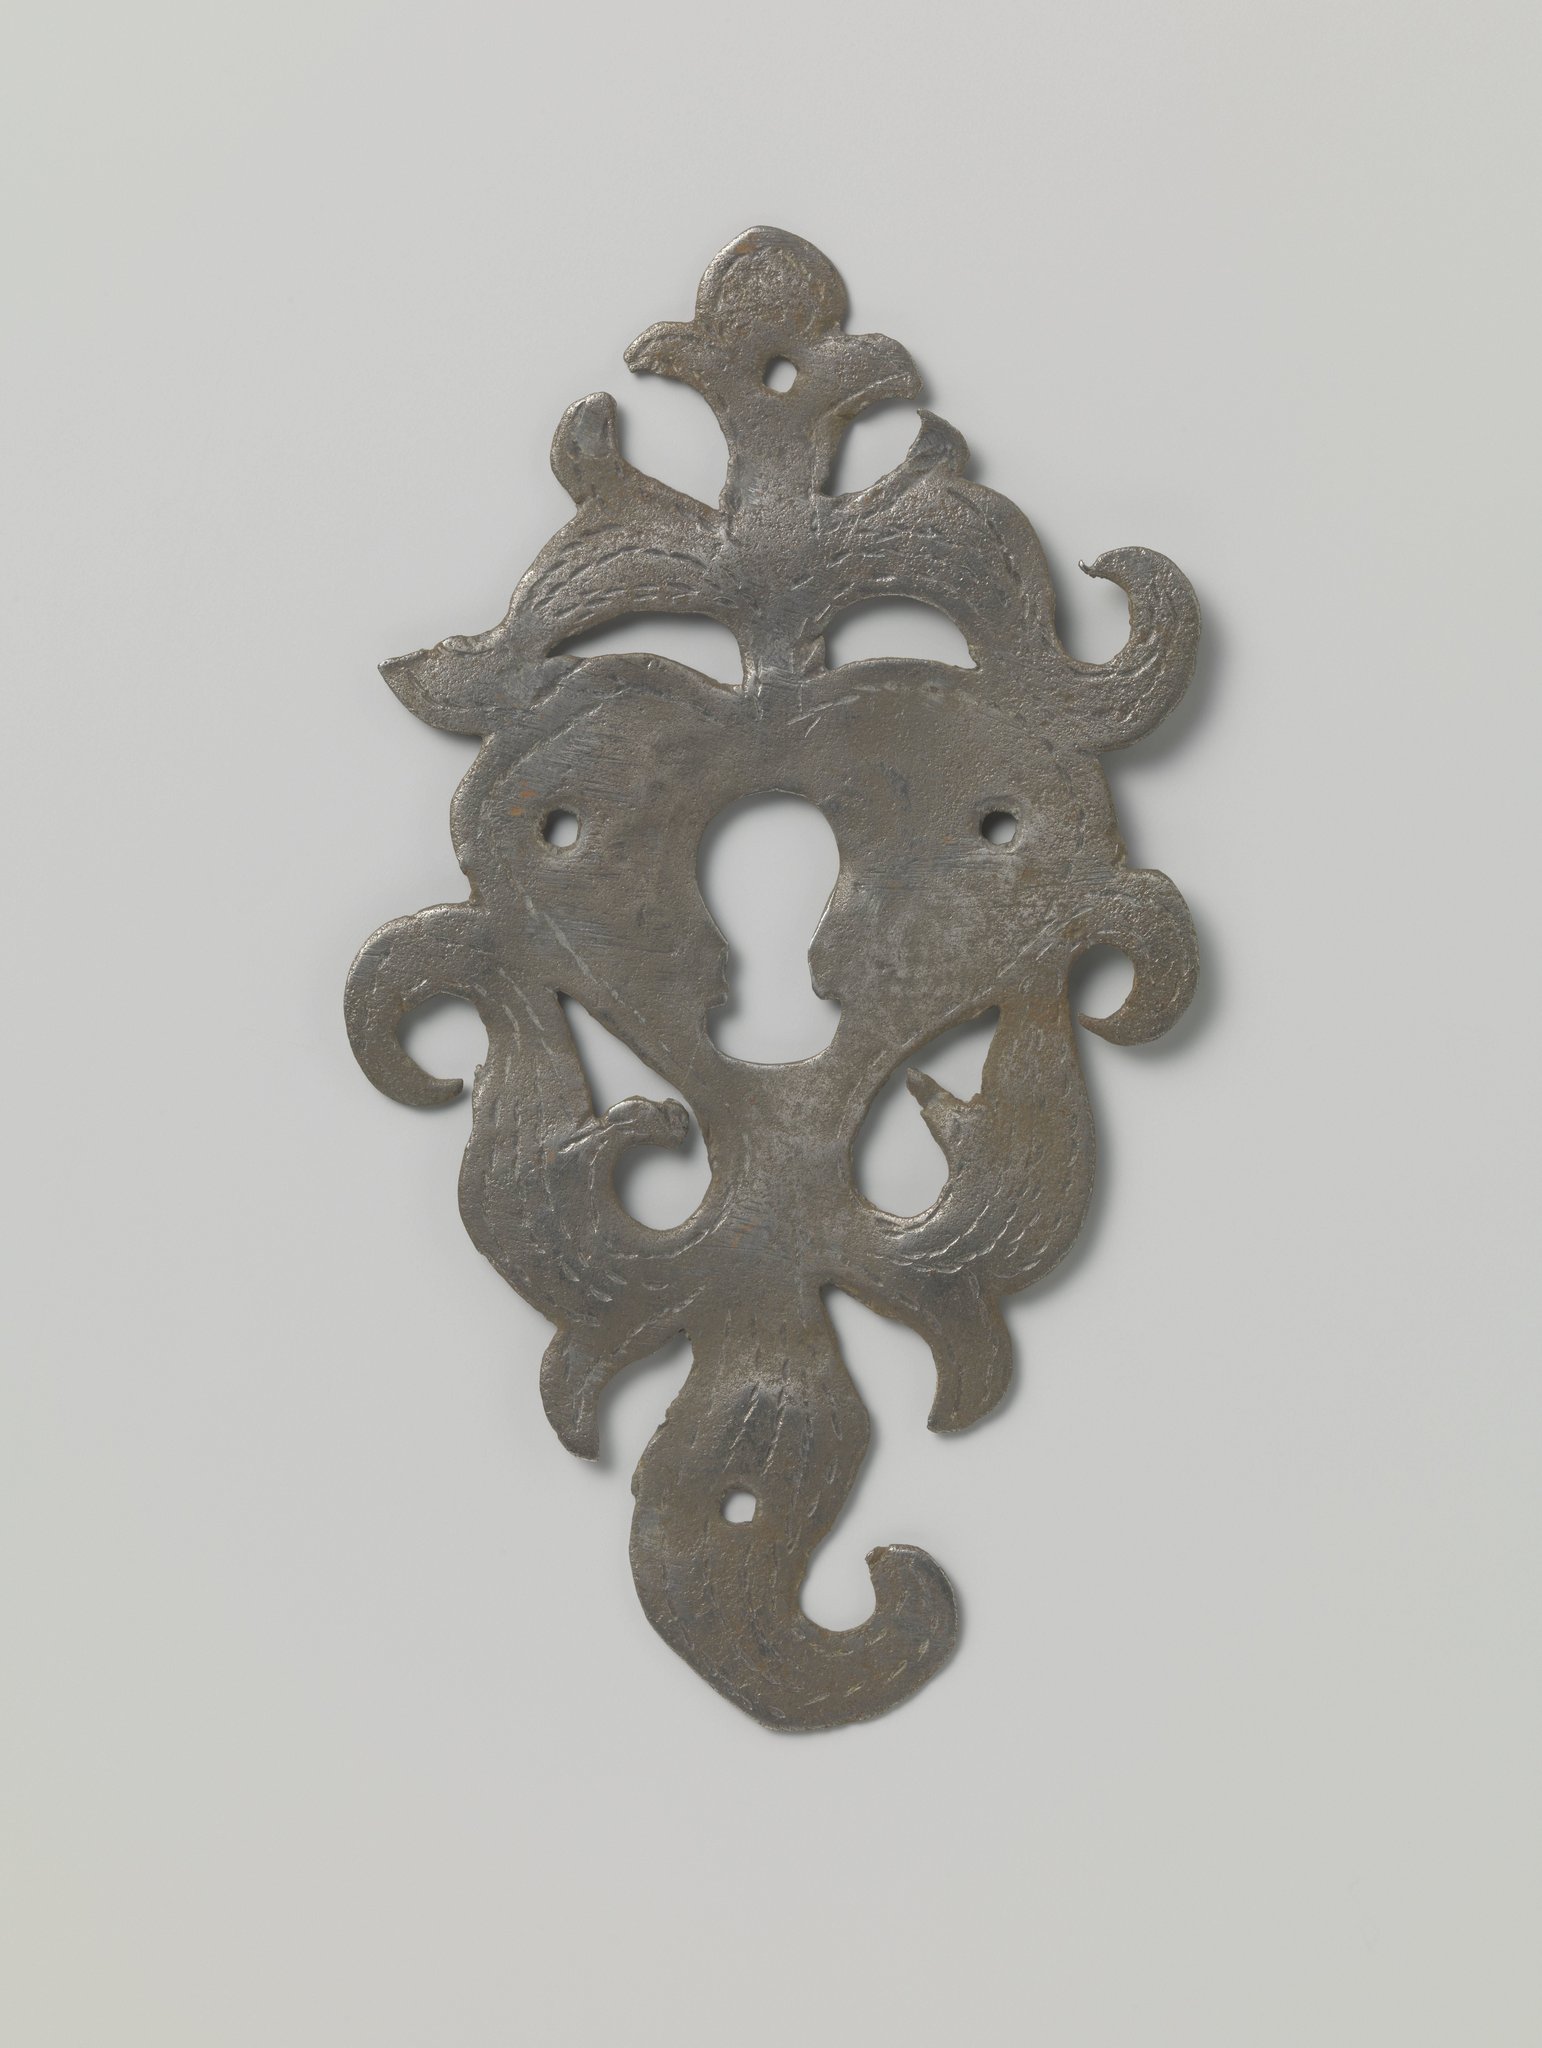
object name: slotplaat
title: Slotplaat van ijzer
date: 1600-1699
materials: iron